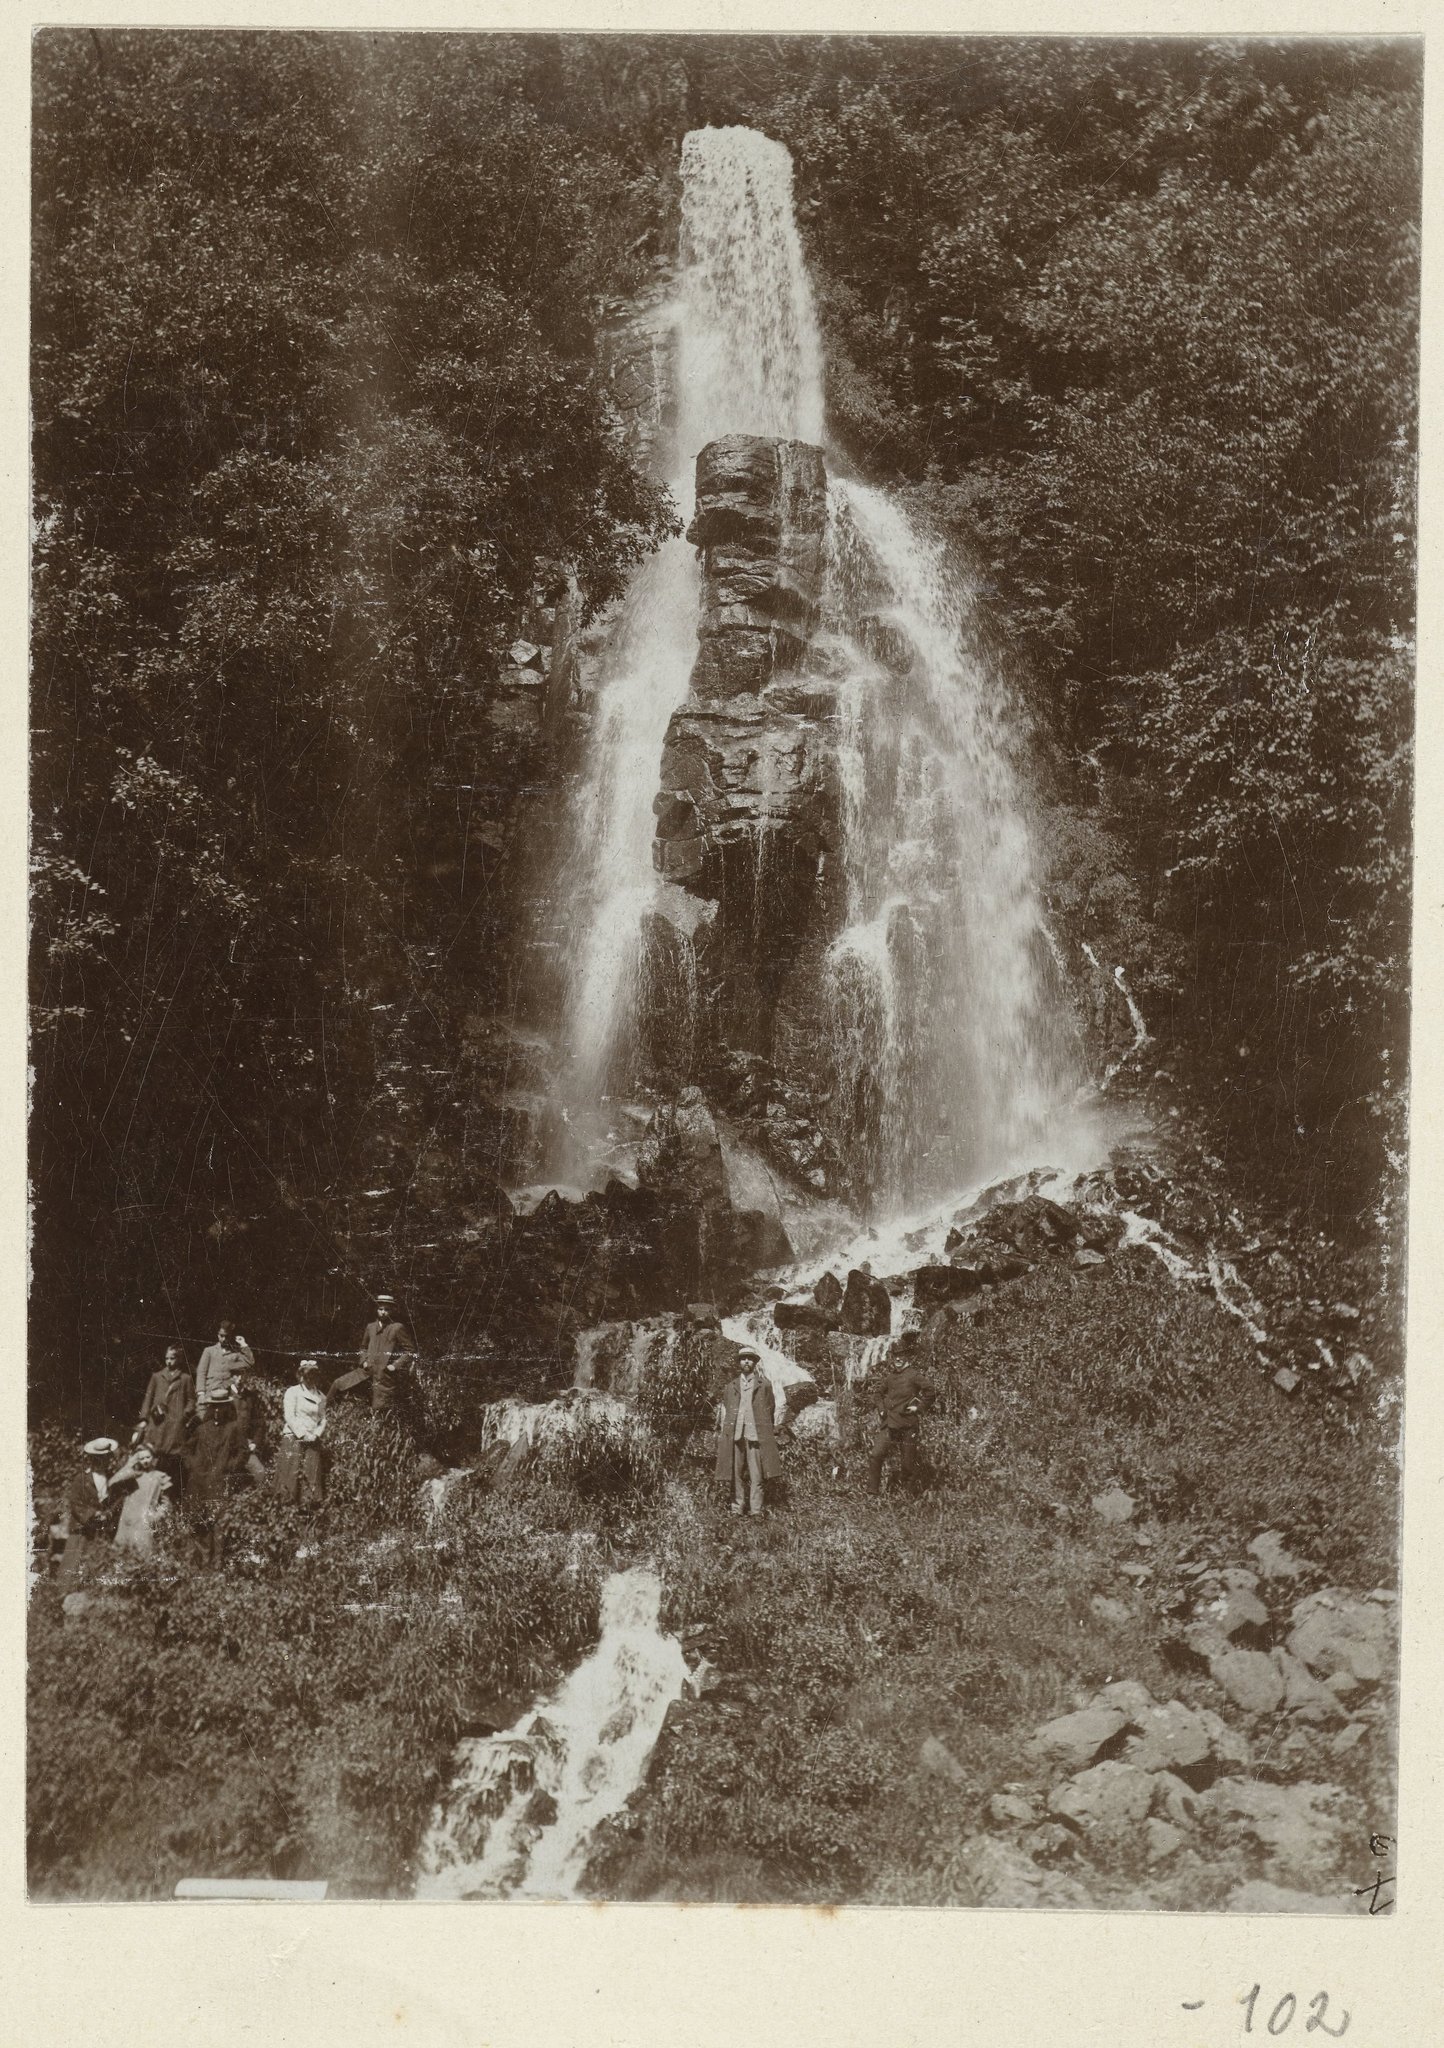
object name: photograph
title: Portret van de families Kessler en Heyning onder aan een bergwaterval in de Harz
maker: geldolph adriaan kessler (dolph)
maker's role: fotograaf, industrieel, voetballer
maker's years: 1884-1945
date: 1903-1908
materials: cardboard, photographic support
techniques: gelatin silver print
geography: harz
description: Portret van de families Kessler en Heyning onder aan een bergwaterval in vermoedelijk de Harz. Onderdeel van het fotoalbum van Dolph Kessler met opnamen die hij maakte tijdens zijn verblijf in Engeland en op een wereldreis die hij als secretaris van Henri Deterding (directeur Koninklijke Olie) ondernam naar Nederlands-Indië, Japan, China en de Verenigde Staten, tussen 1906 en 1908.